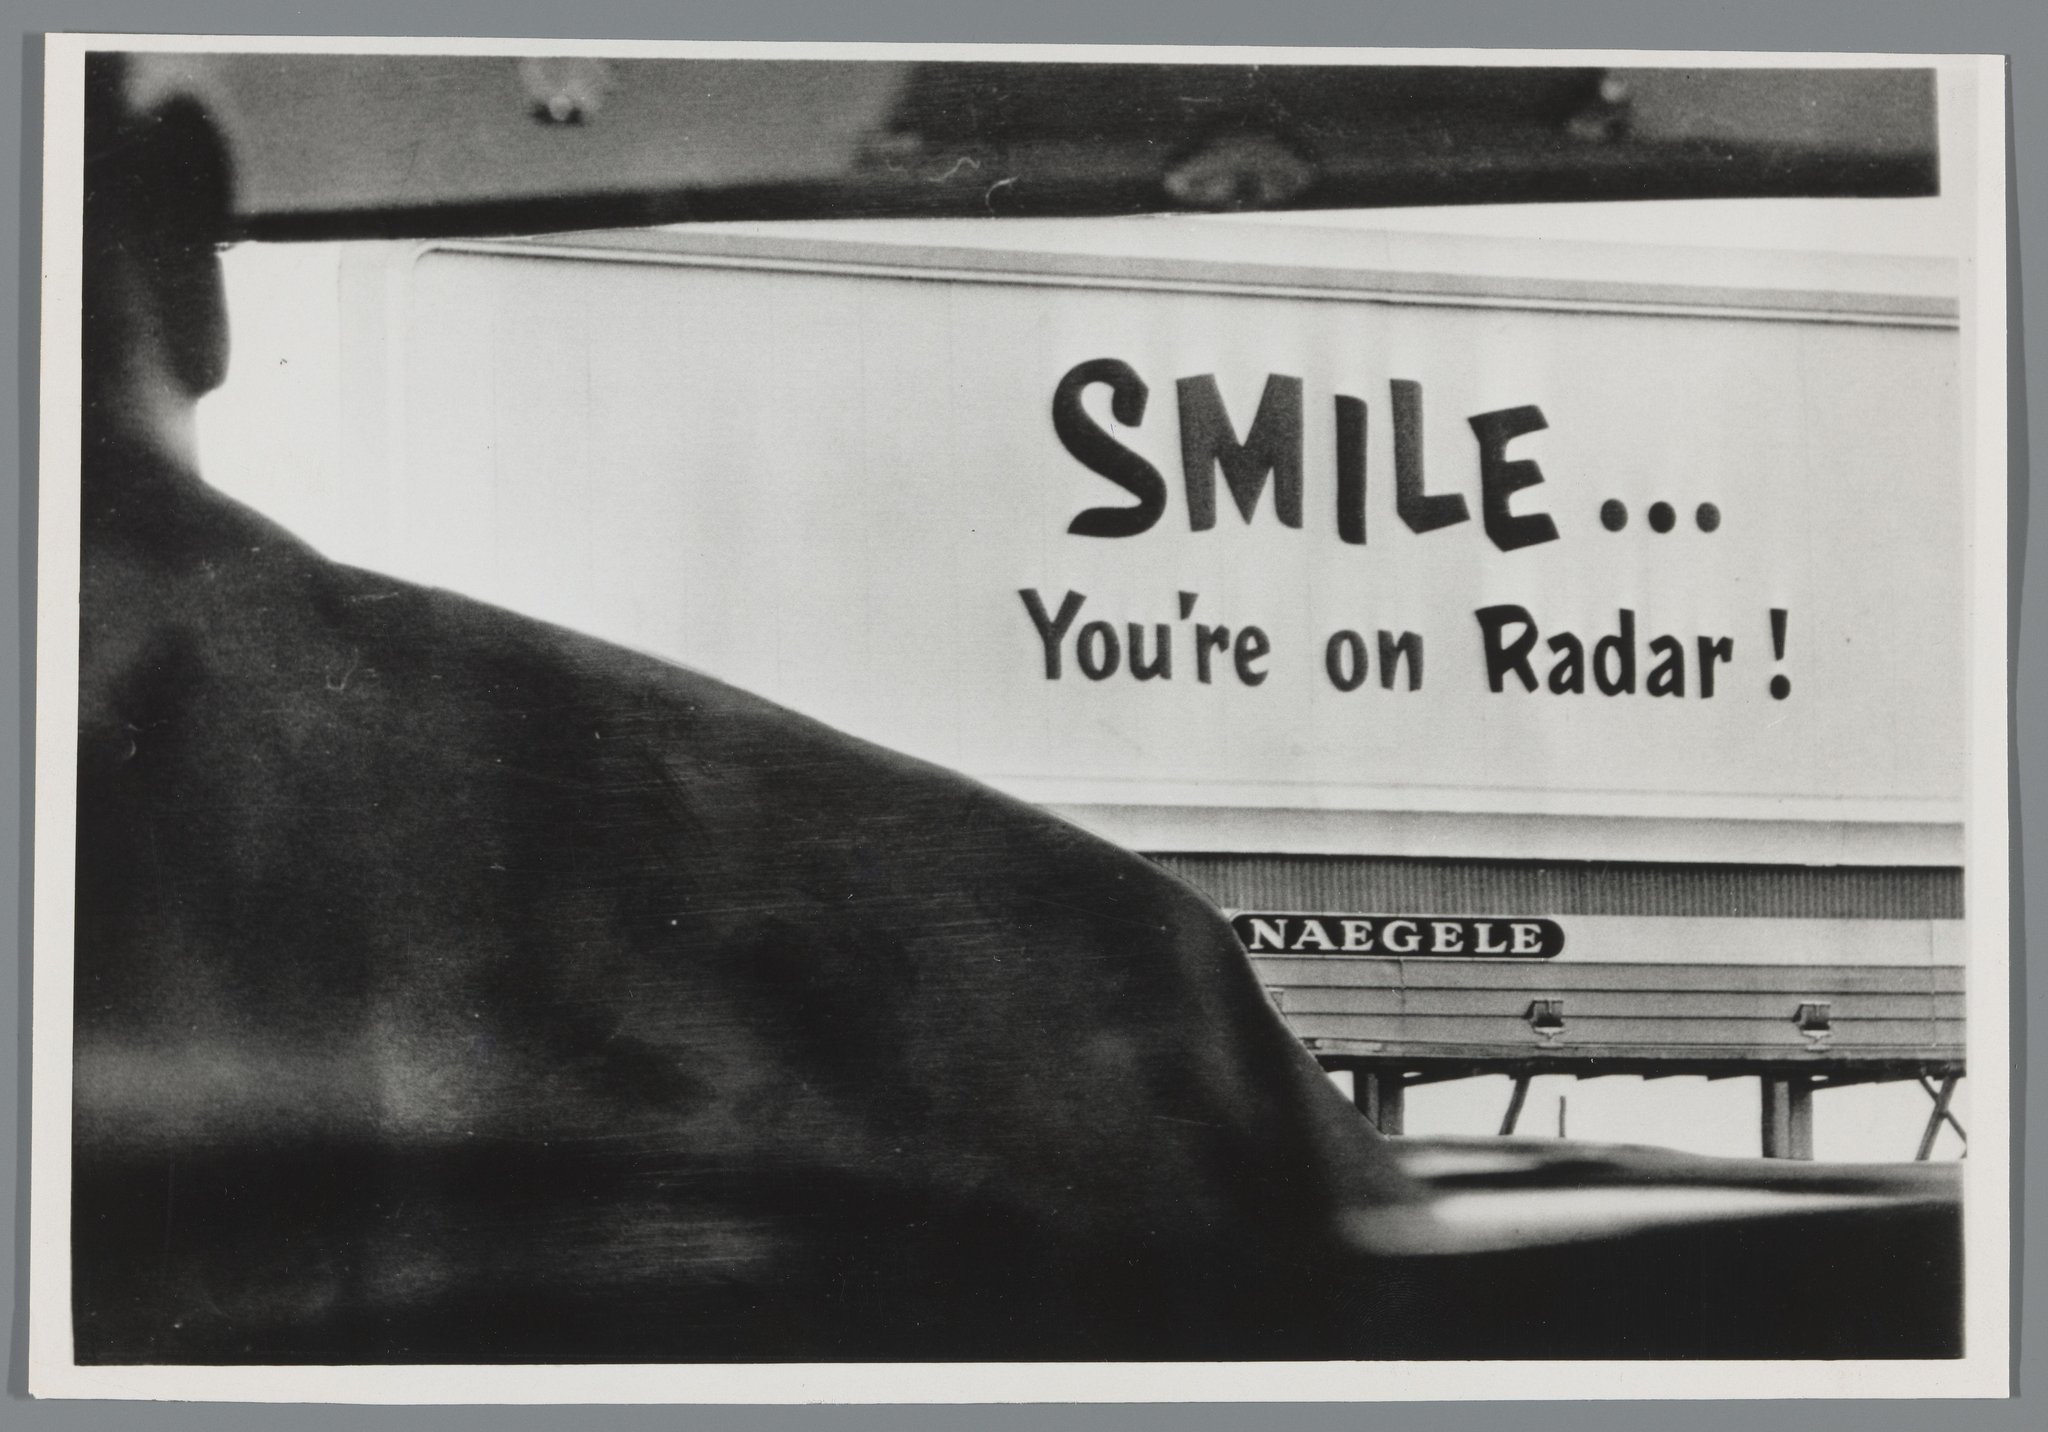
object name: photograph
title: Uitzicht vanuit een rijdende auto op billboard “SMILE, You’re on Radar!"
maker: Anonymous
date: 1965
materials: photographic support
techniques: gelatin silver print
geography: north and central america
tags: united states of america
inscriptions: stamp: ‘HIGHWAY/US” en “RECEIVED EXAMINER / REFERENCE LIBRARY / OCT 12 1965"’